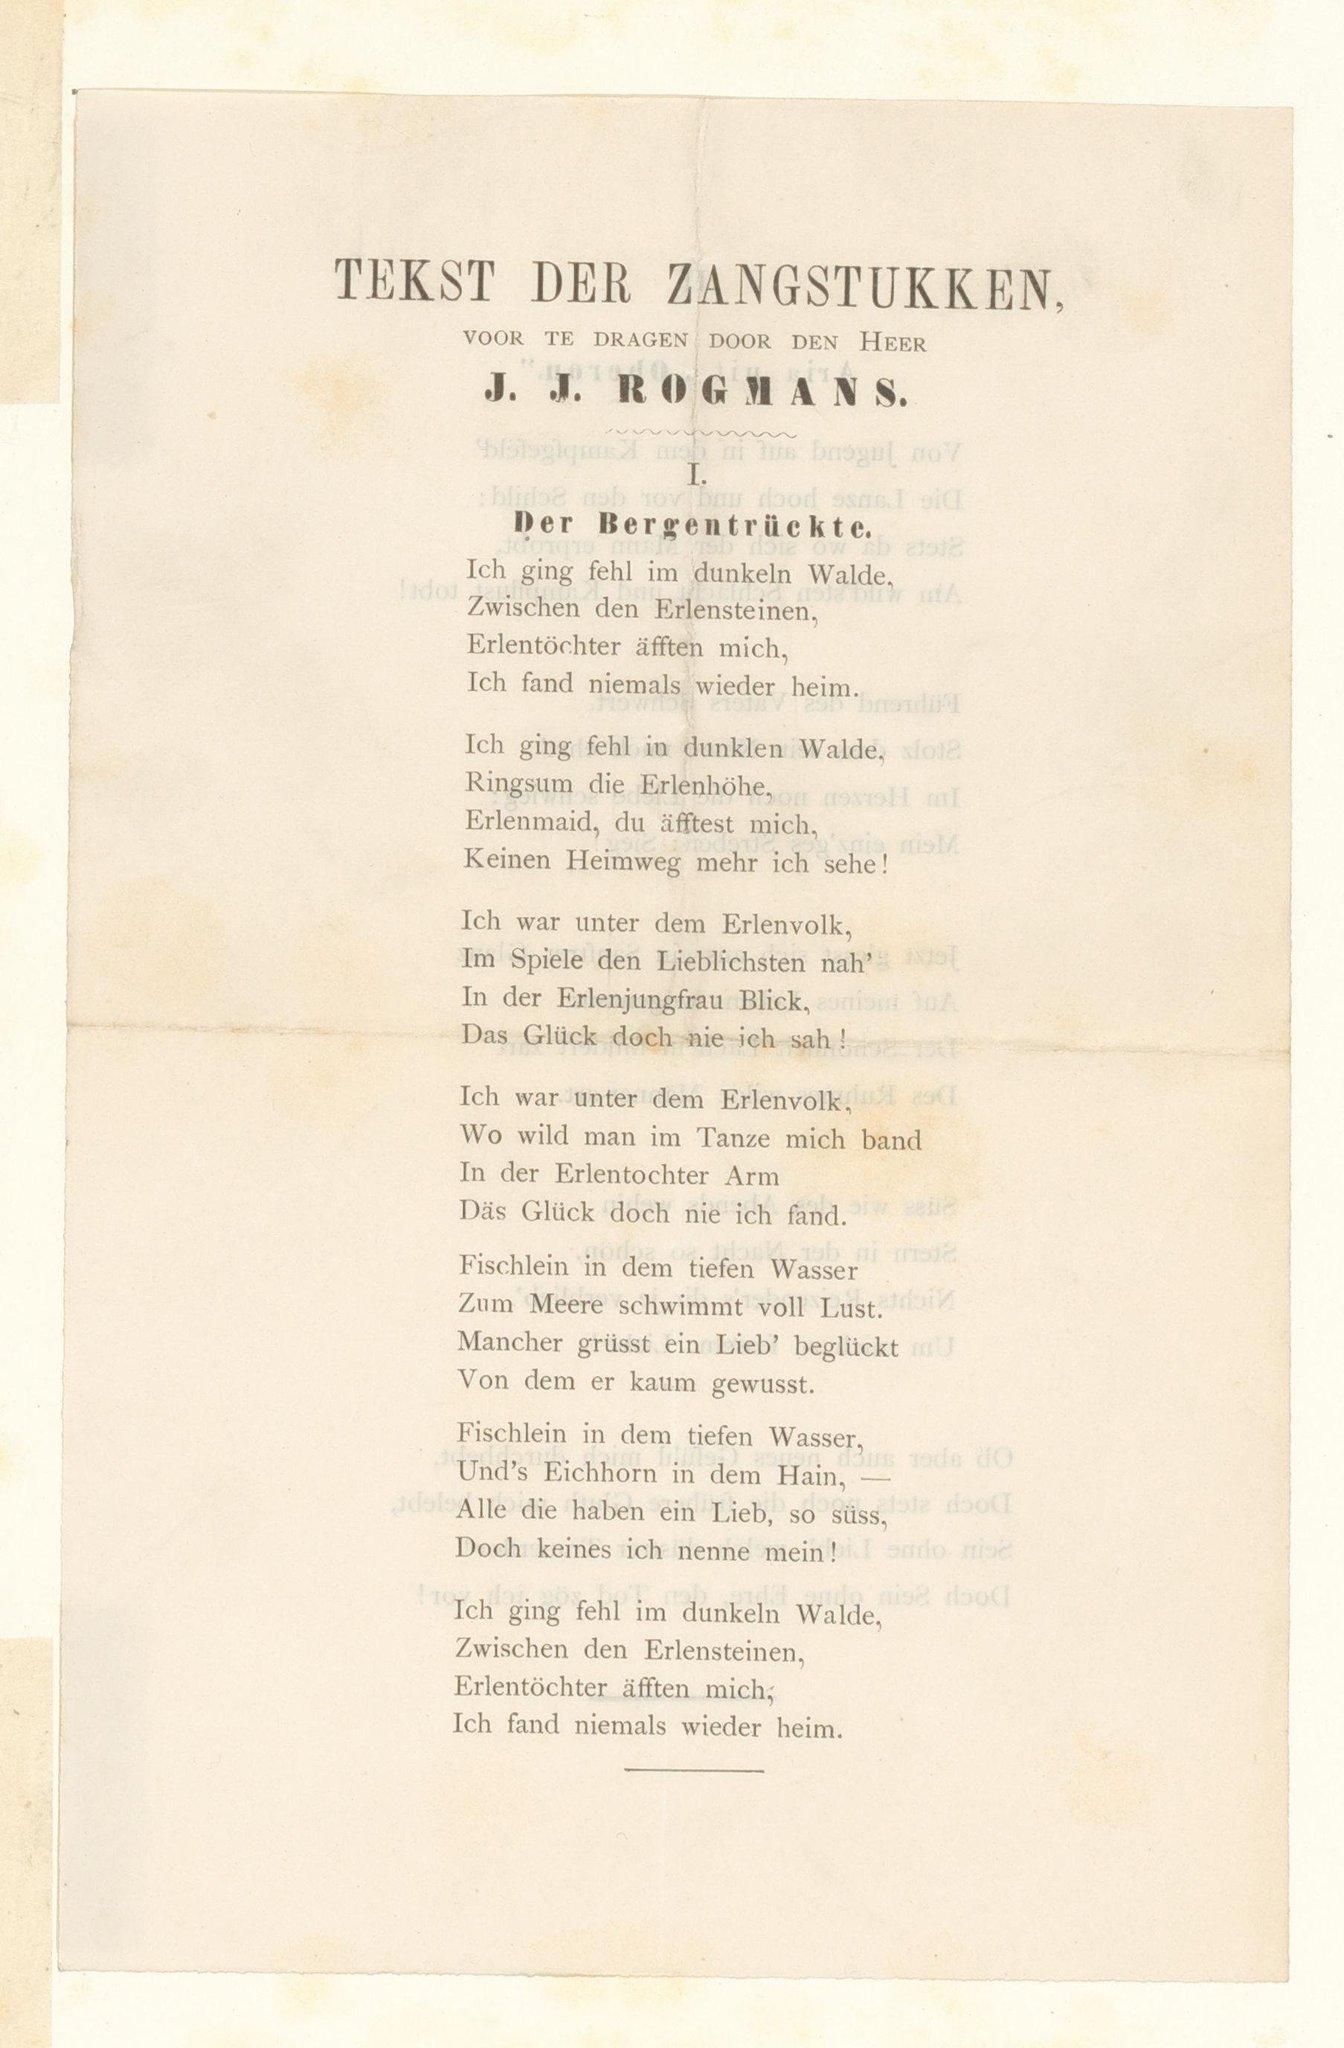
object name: text sheet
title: Tekst van de zangstukken bij het programma voor een concert in Felix Meritis op 25 maart 1887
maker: Anonymous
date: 1887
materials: paper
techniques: letterpress printing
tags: julius röntgen, listening to music, large group of musicians, orchestra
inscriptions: collector's mark: Lugt 1641, collector's mark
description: Blad met de tekst van de zangstukken, behorende bij het gedrukte programma voor het Zevende Concert door het orkest onder leiding van Julius Röntgen, in Felix Meritis te Amsterdam op 25 maart 1887. Onderwerpsrubrieken binnen de Atlas Zeden en Gewoonten: Muziek en muziekinstrumenten: Varia.